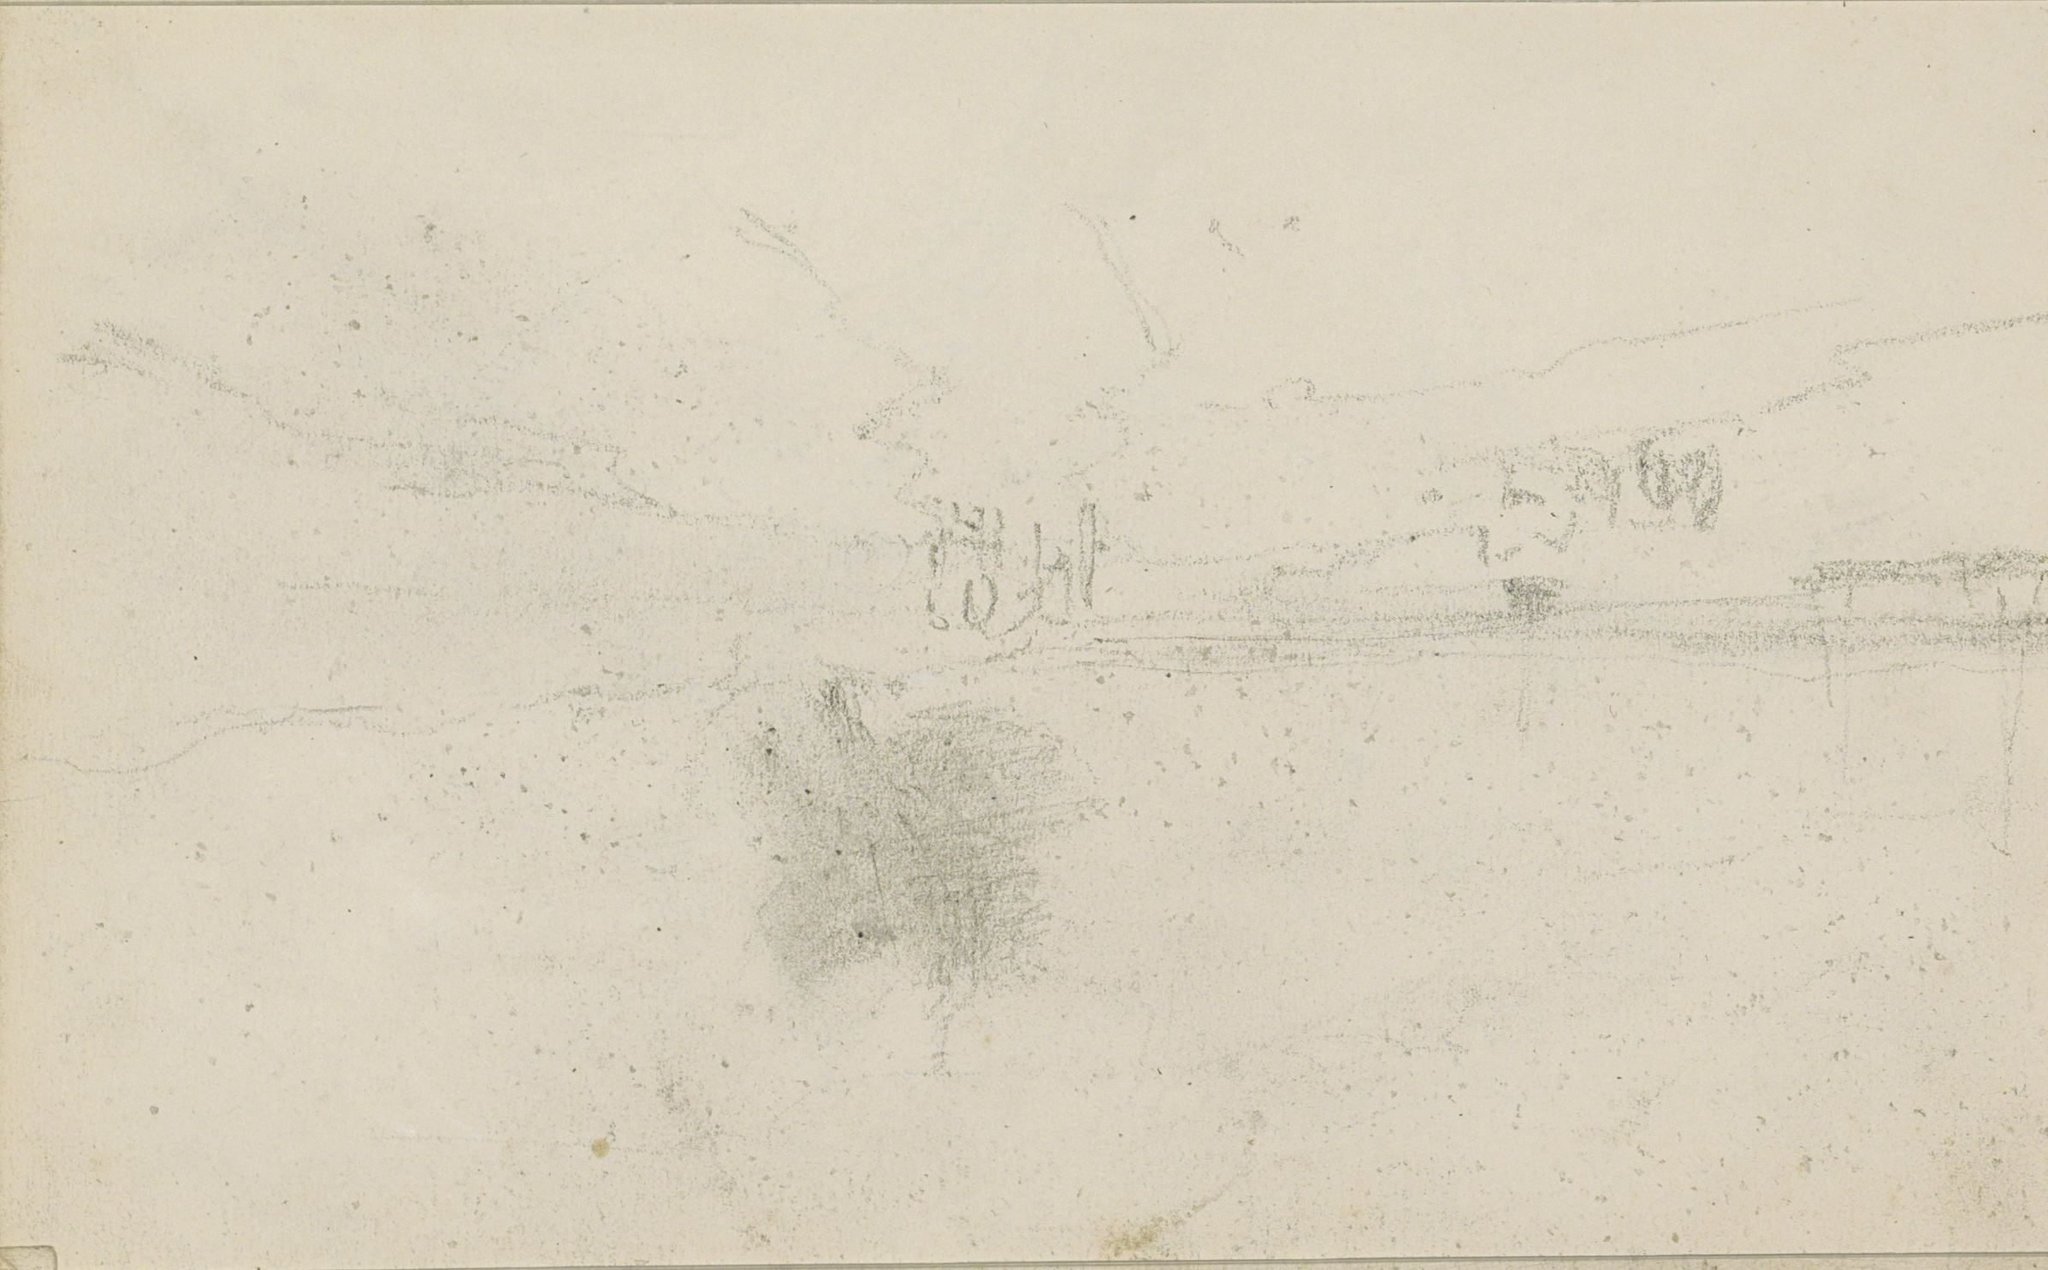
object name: sketchbook leaf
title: Landschap met water en een paardenkar op het land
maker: anton mauve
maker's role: draughtsman, painter, print maker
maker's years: 1838-1888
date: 1848-1888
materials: paper, pencil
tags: landscapes with waters, waterscapes, seascapes (in the temperate zone), (farm) wagon, freight wagon, cart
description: Blad 33 verso uit een schetsboek met 42 bladen.